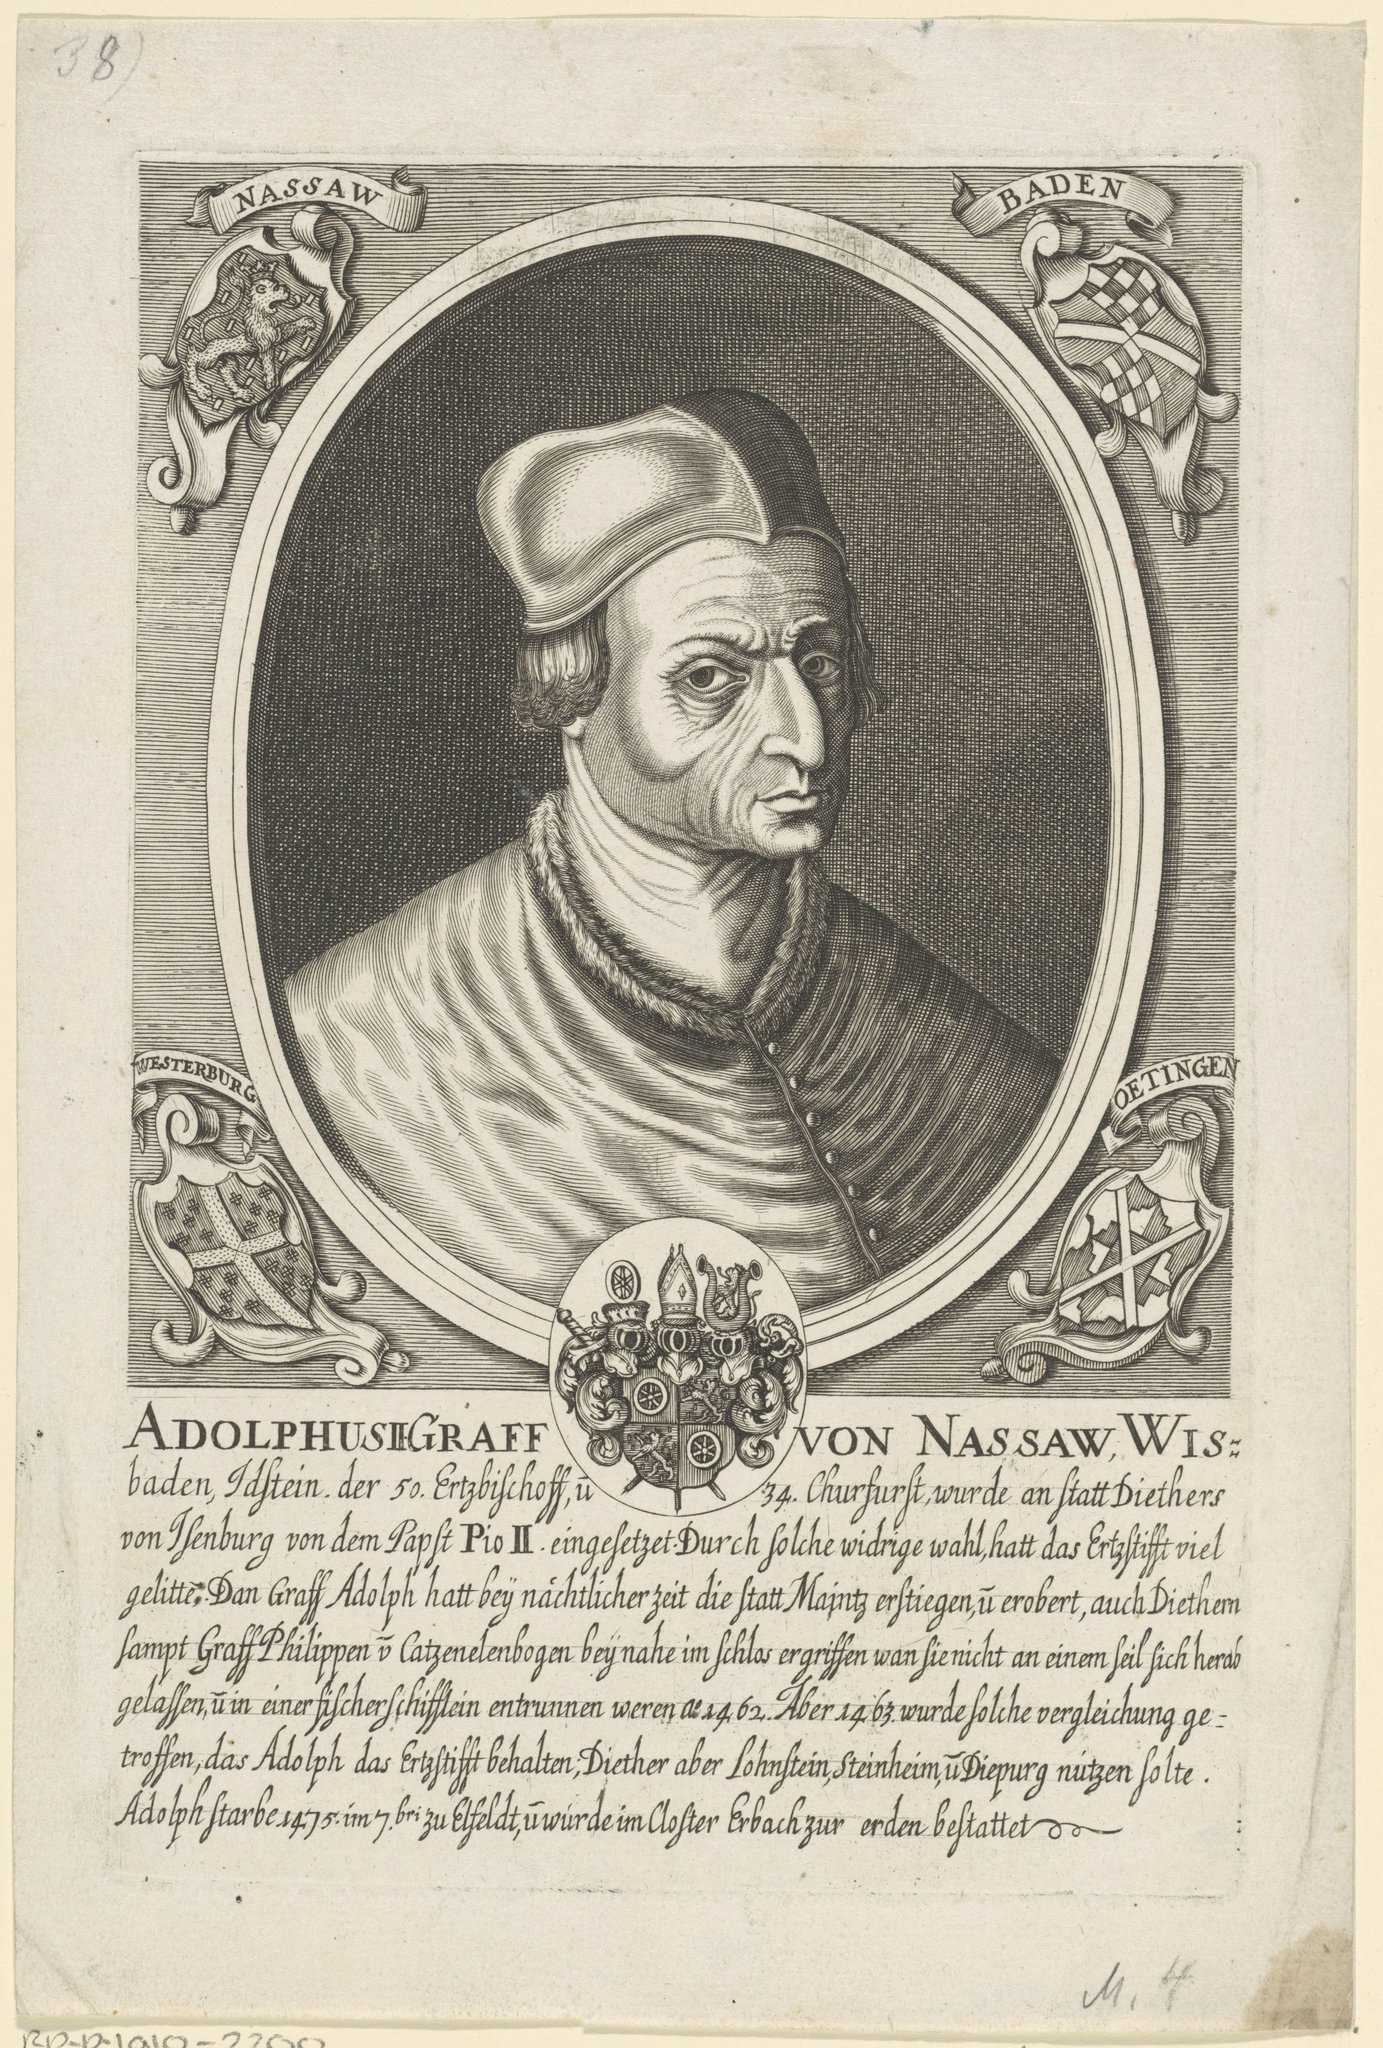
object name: print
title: Portret van Adolf II van Nassau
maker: Anonymous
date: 1600-1699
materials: paper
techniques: engraving, etching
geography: germany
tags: adolf ii van nassau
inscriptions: collector's mark: Lugt 2228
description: Portret van Adolf II in een ovaal. Rondom een aantal wapens. In de ondermarge acht regels Duitse tekst.